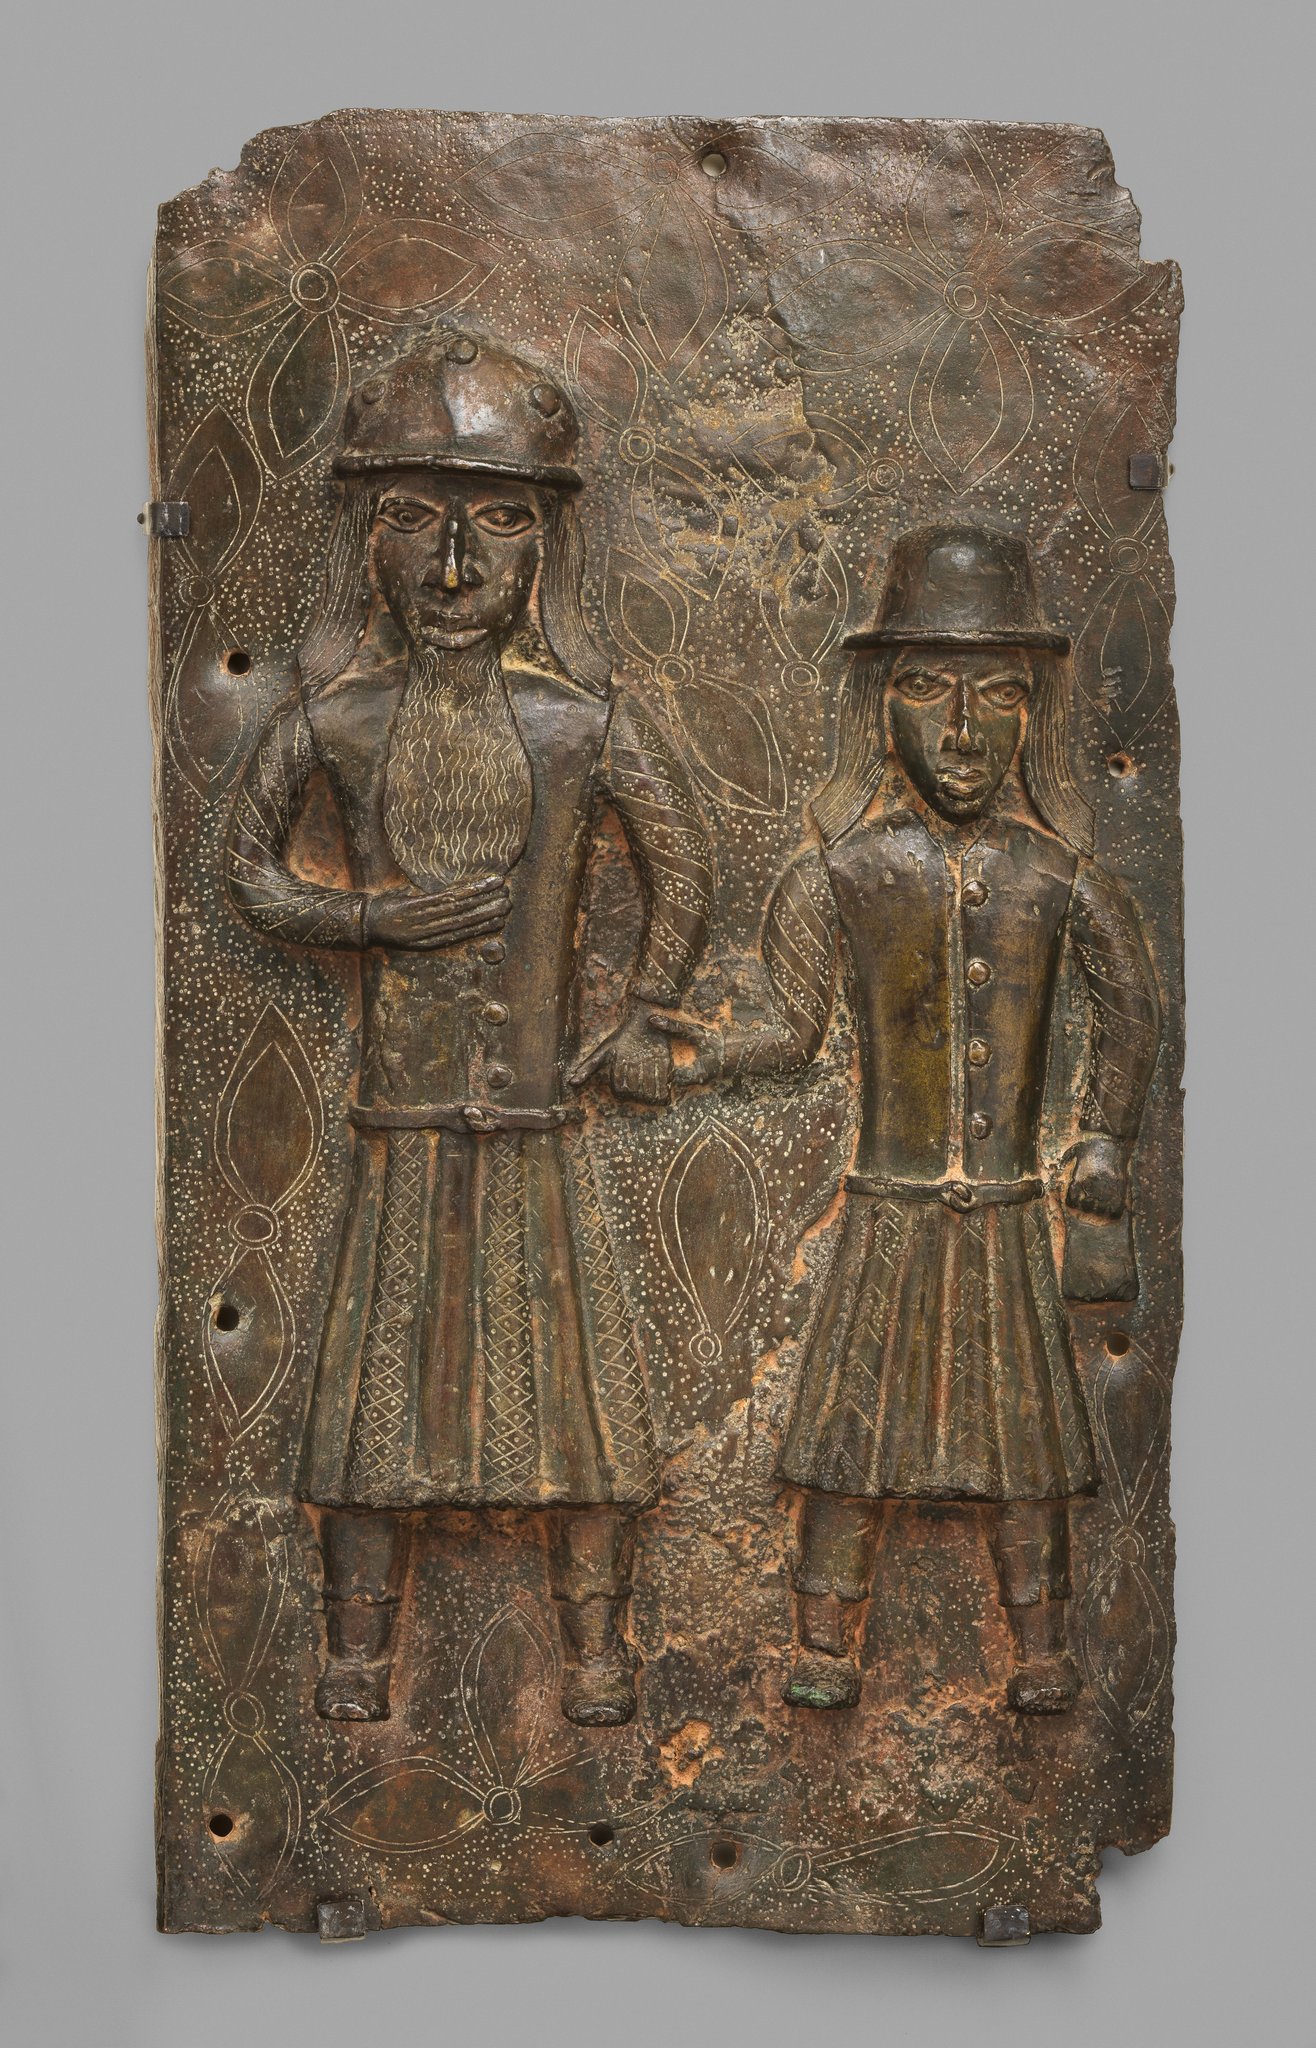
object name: plaque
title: Plaque with Two Portuguese Merchants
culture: edo period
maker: ìgùn ẹ́rọ̀nwwọ̀n (brass-casting guild) artists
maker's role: artist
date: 1540-1570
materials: brass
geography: nigeria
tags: men